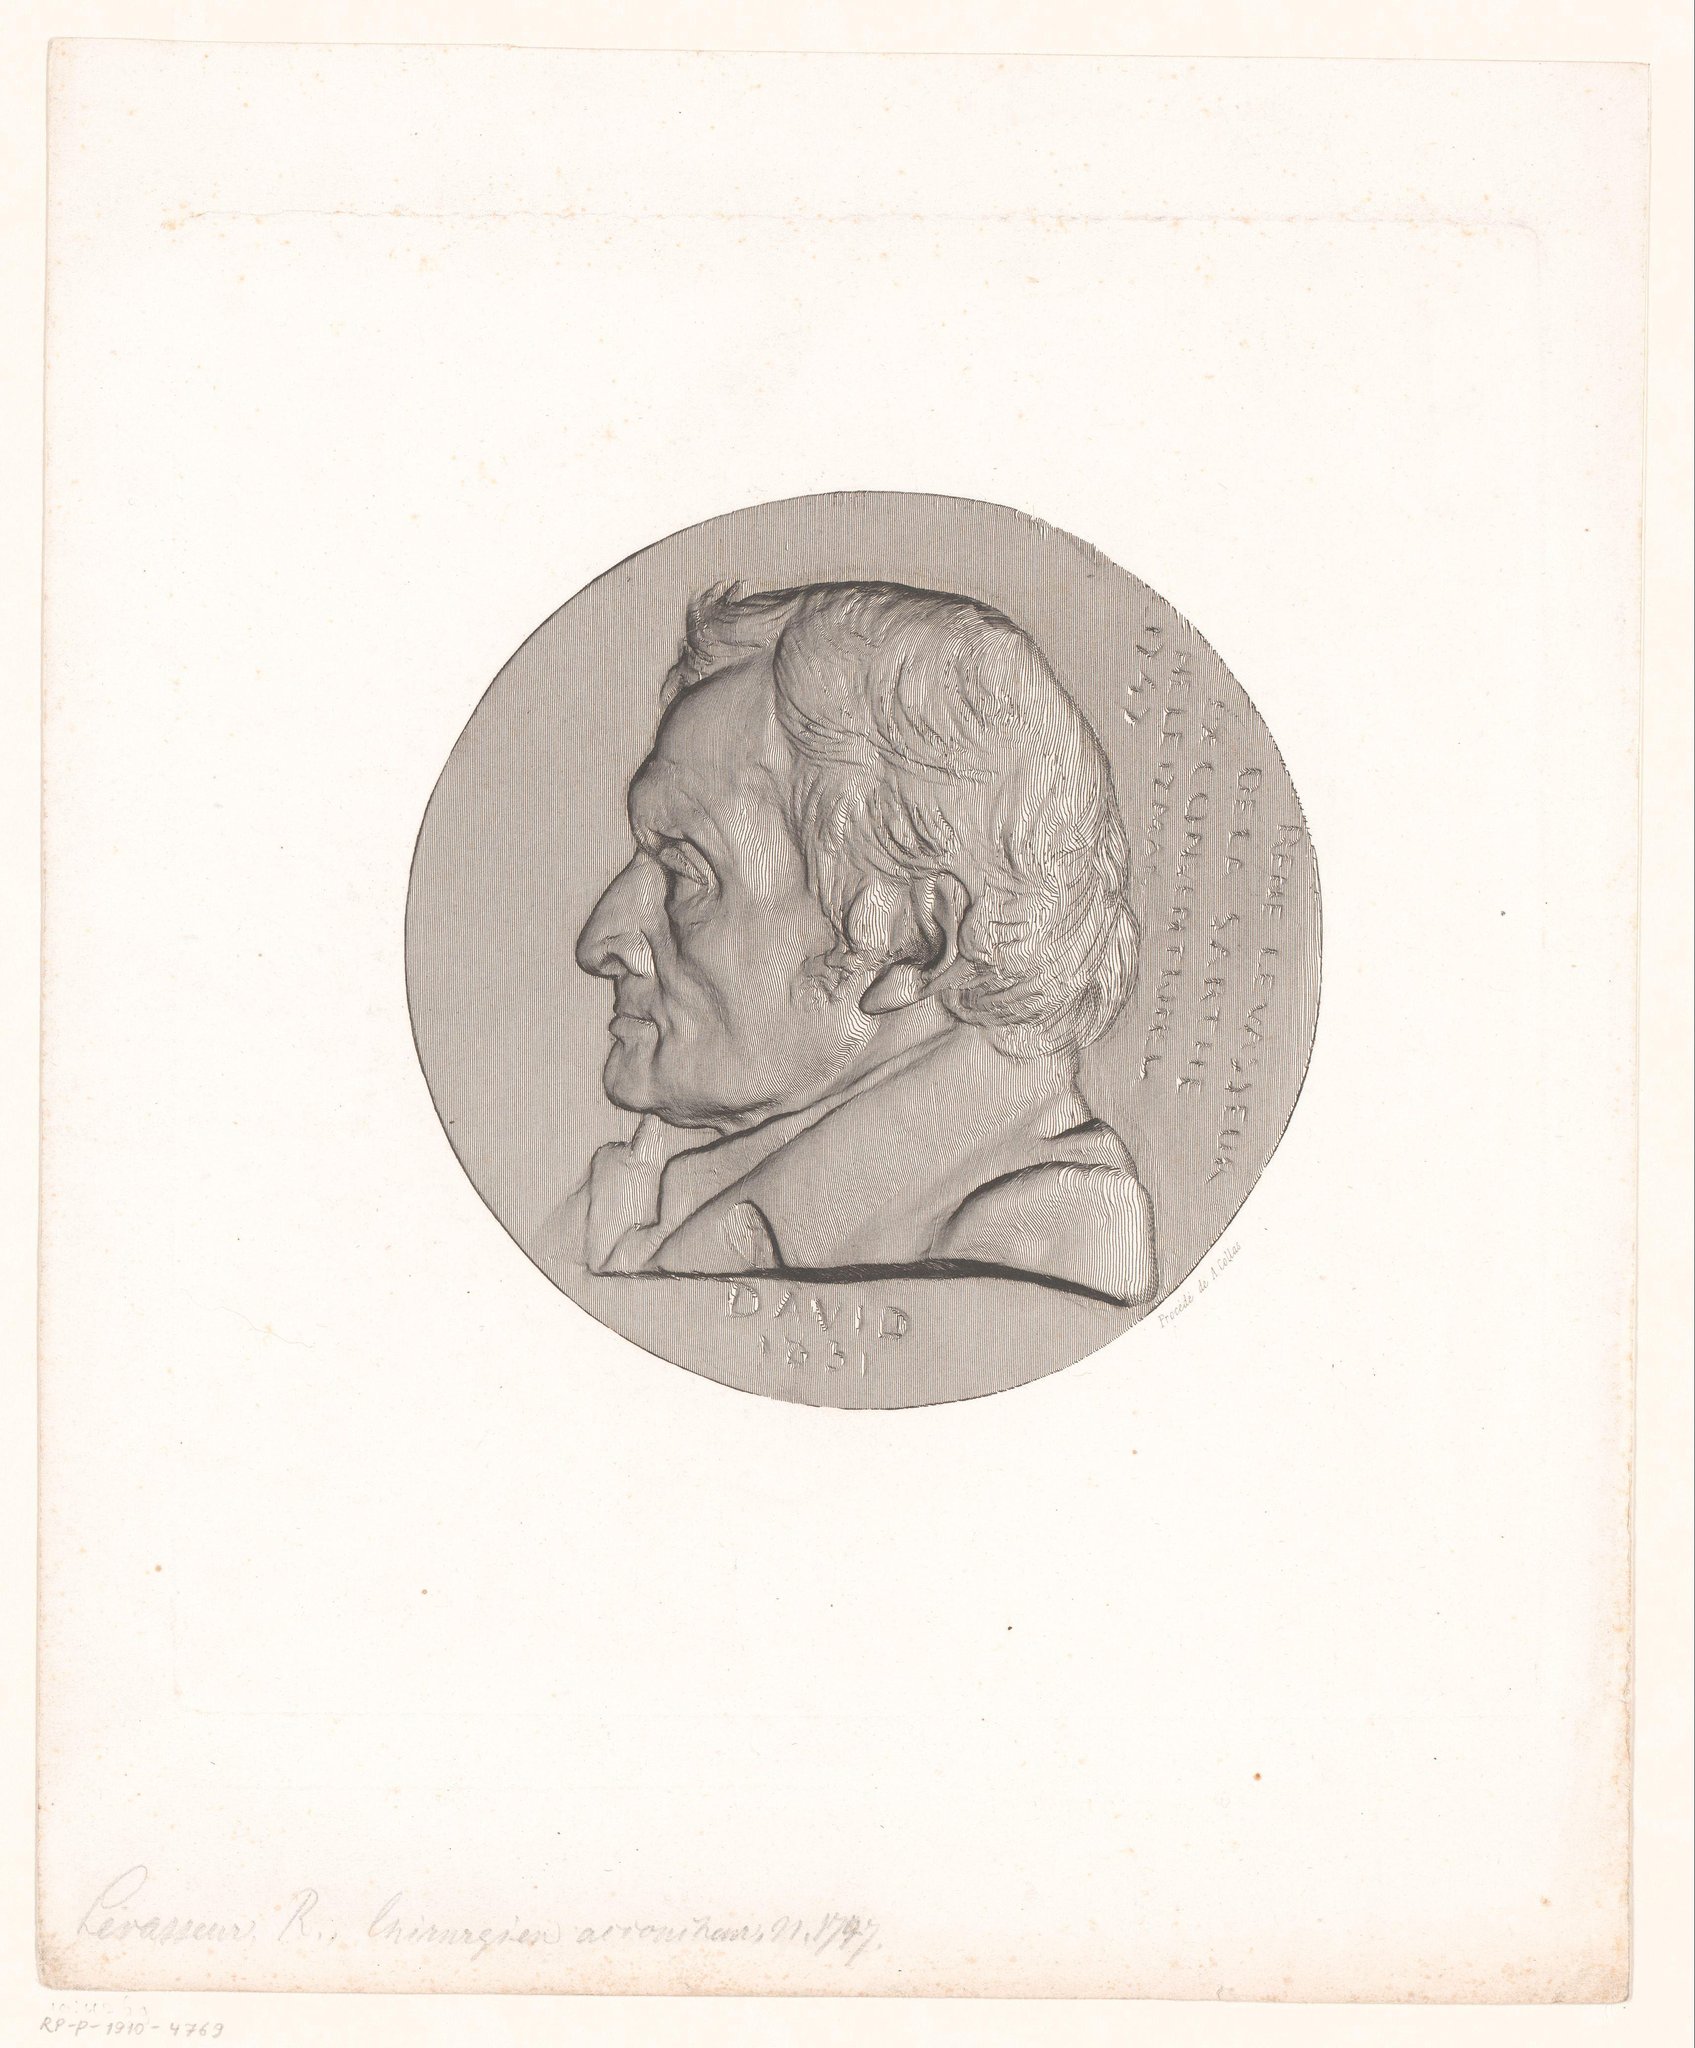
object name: print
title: Serie medaillons met vooraanstaande figuren uit het begin van de negentiende eeuw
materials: paper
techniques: relief engraving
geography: france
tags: politician, ornament ~ medallion, historical persons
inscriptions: collector's mark: Lugt 2228